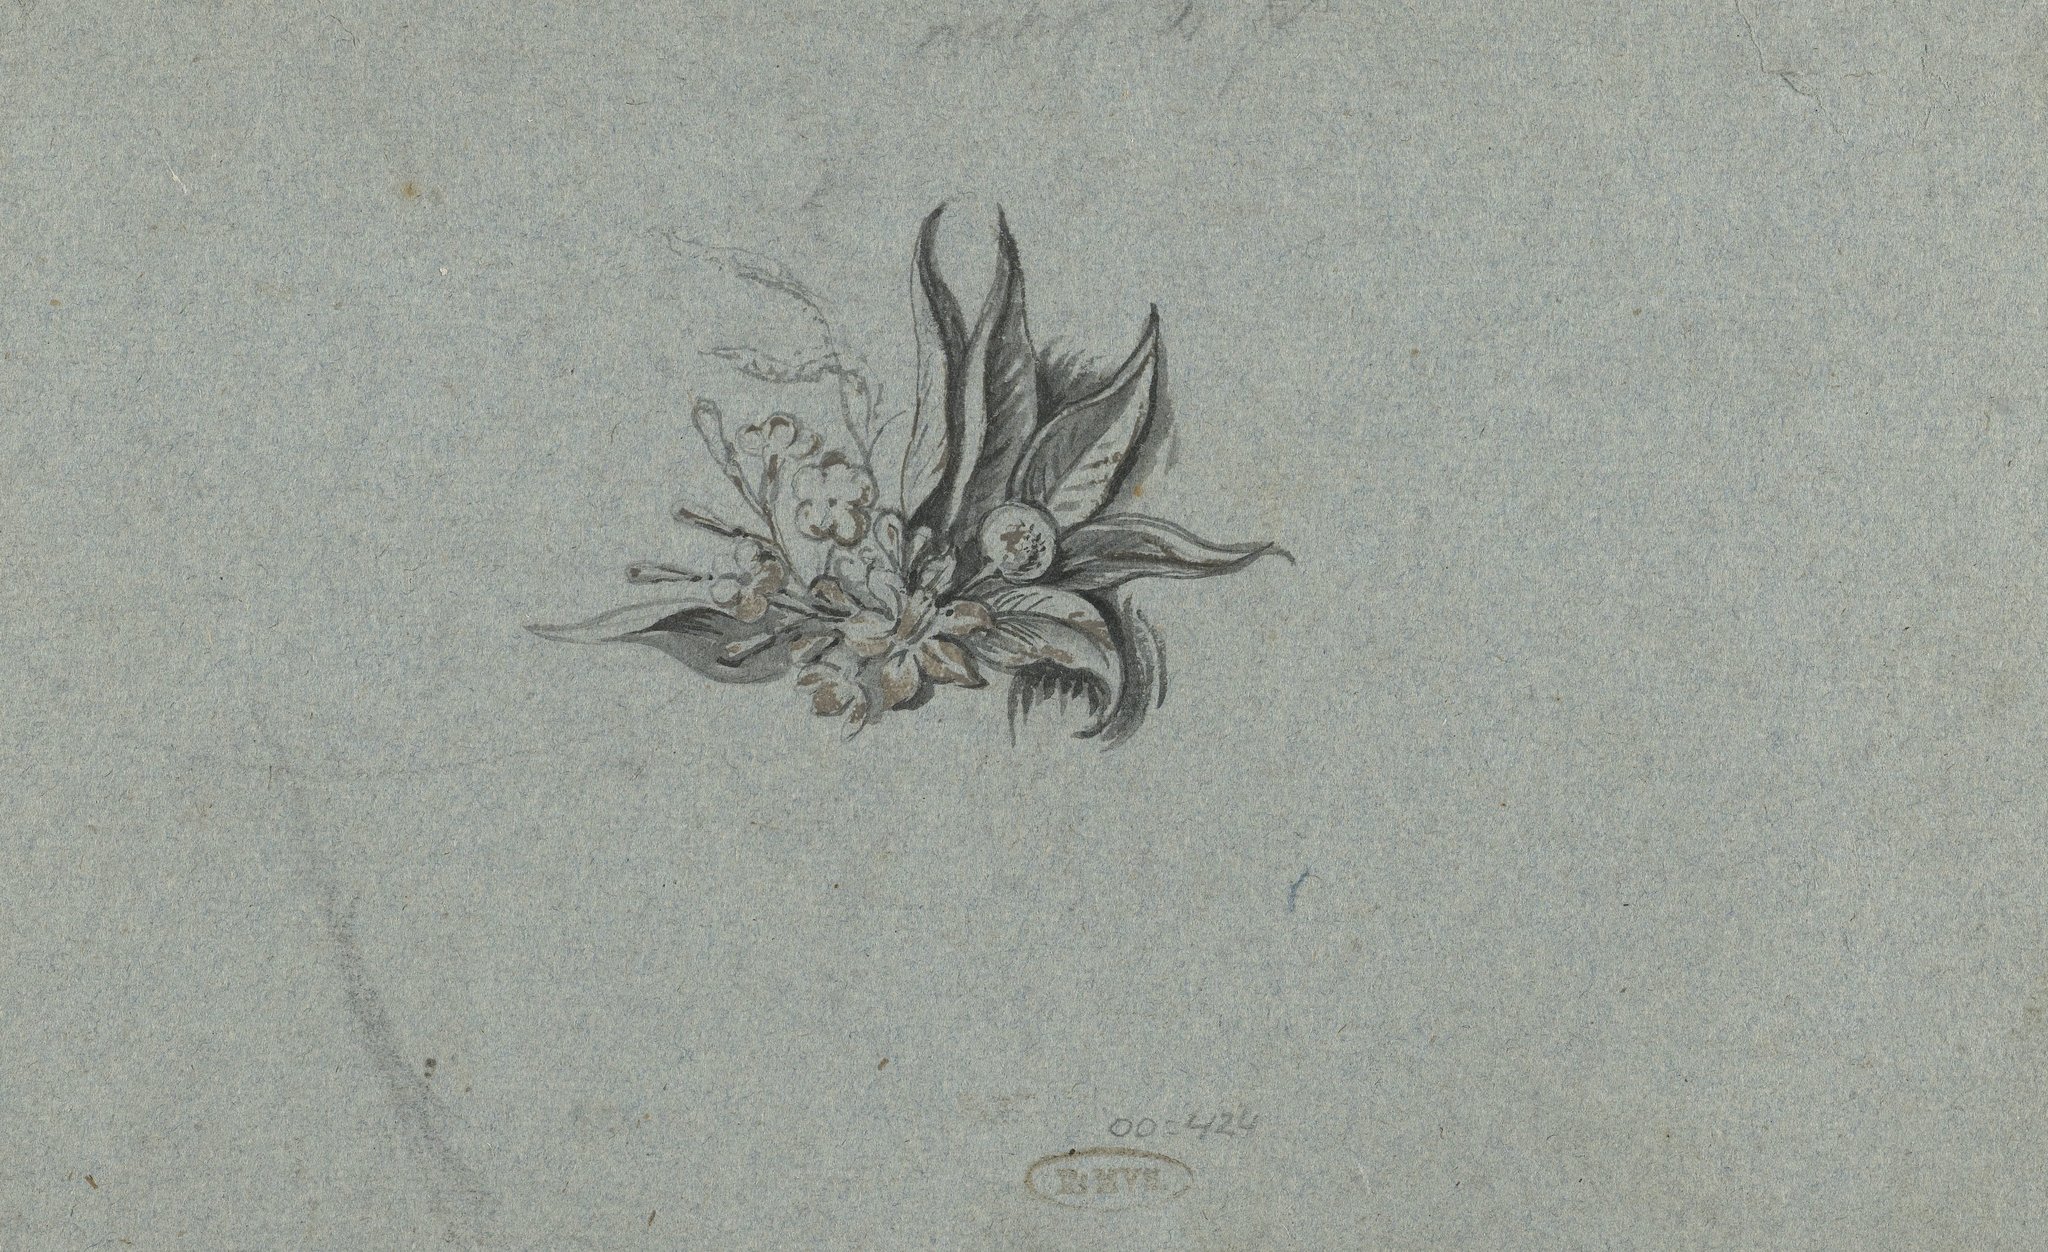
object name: drawing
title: Plantstudie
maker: anthony van dyck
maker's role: draughtsman, painter, print maker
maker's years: 1599-1641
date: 1610-1641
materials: ink, paper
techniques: brush, pen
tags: plants; vegetation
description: Afkomstig uit een tekeningenalbum met onder andere figuur- en handstudies van of naar Caspar en Constantijn Netscher (BI-1894-3720). Tekening bevond zich oorspronkelijk op f. 34.